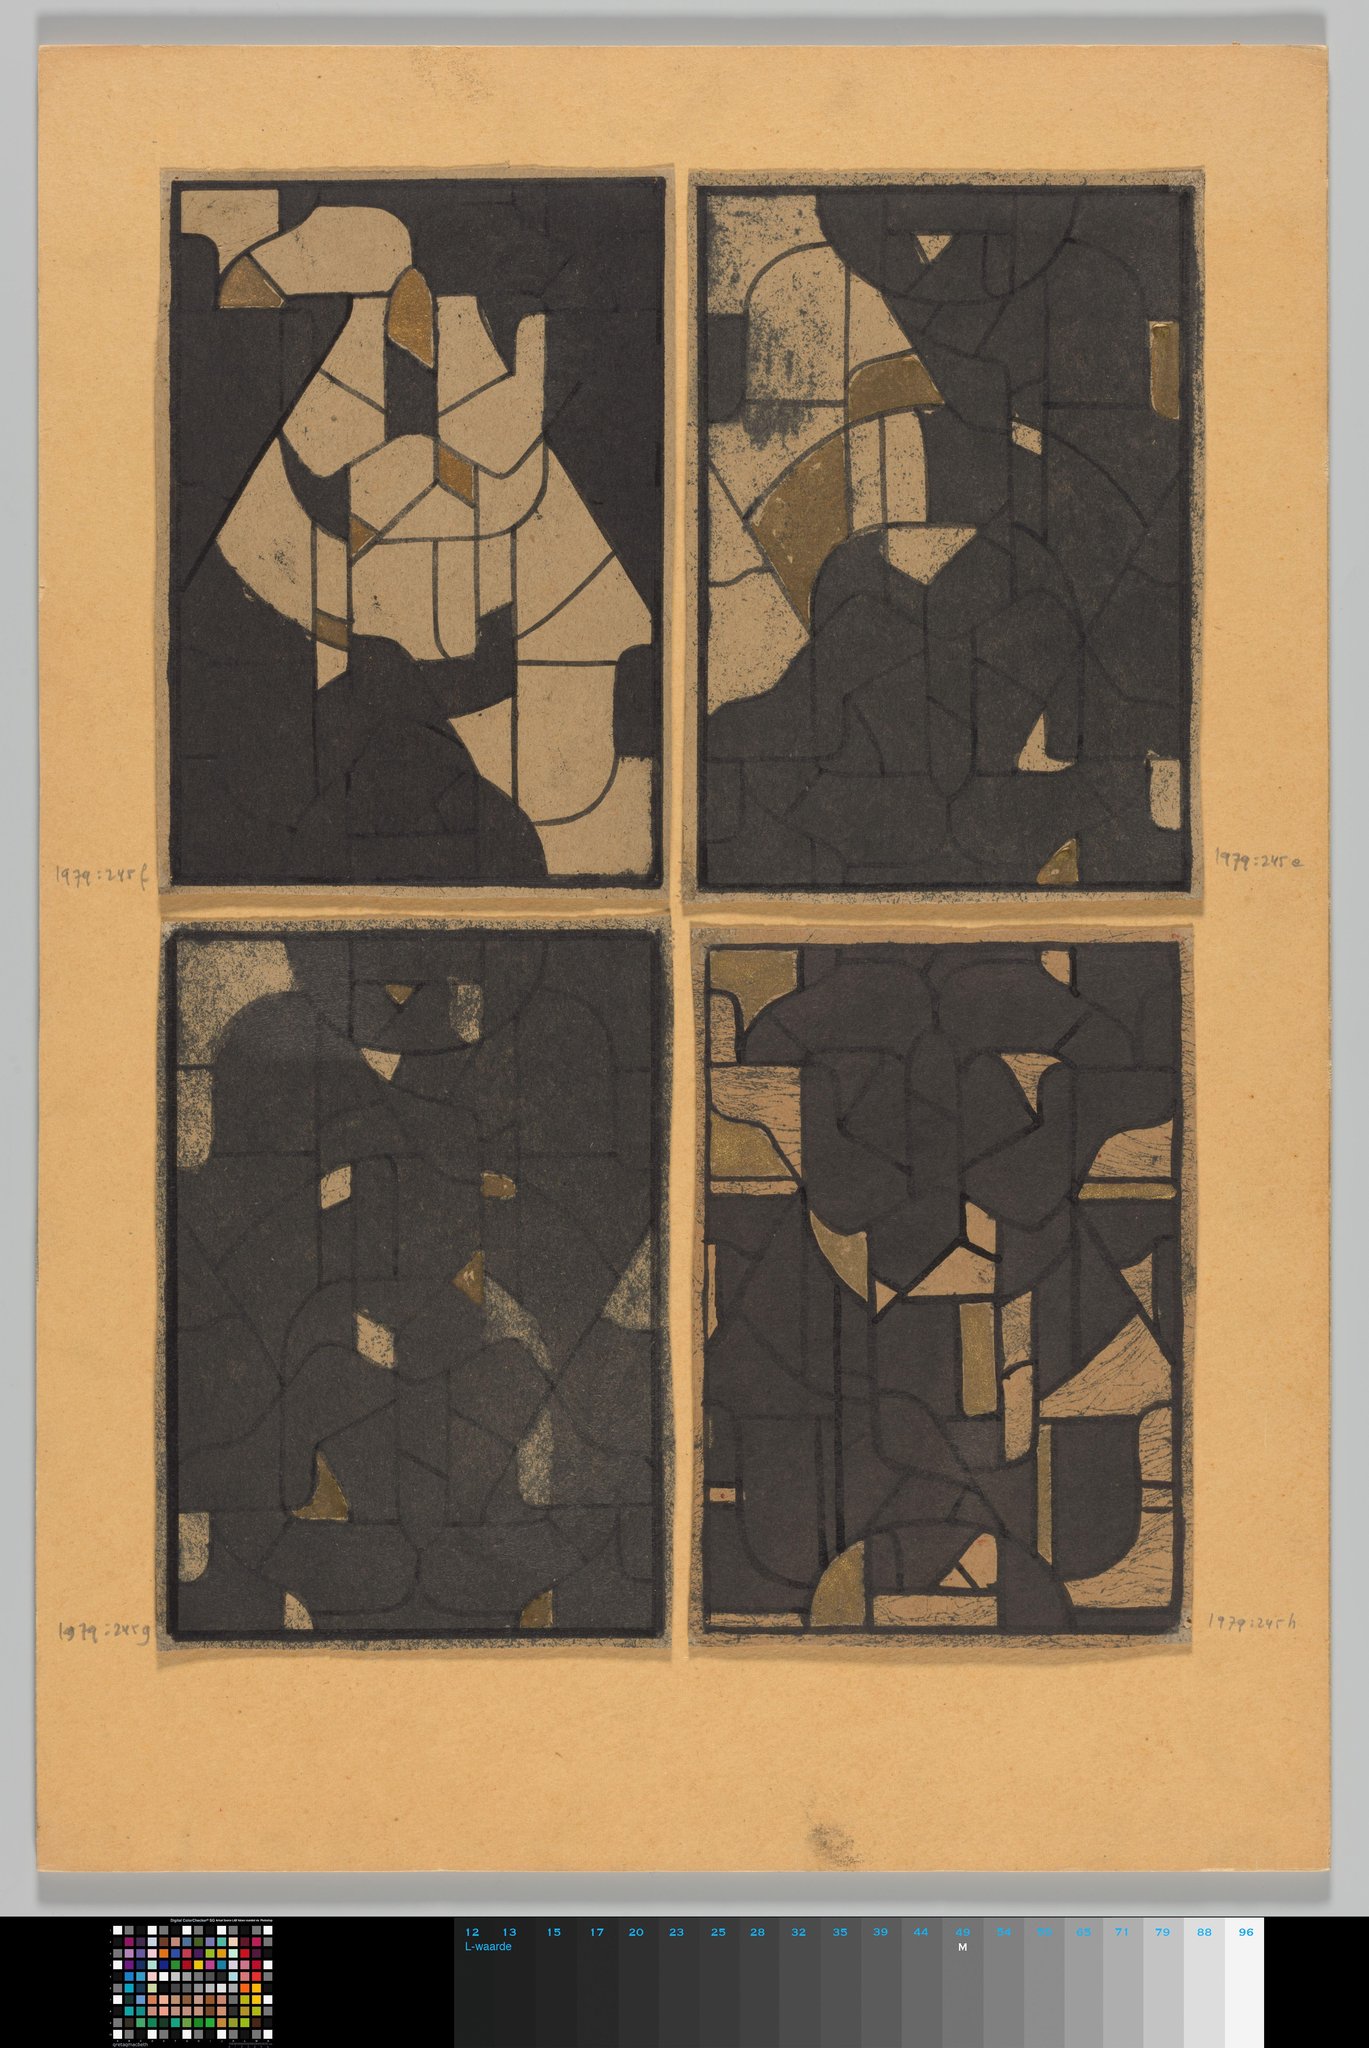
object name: drawing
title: Tapijtontwerp voor raam in het Noordertransept van de Dom te Utrecht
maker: richard nicolaüs roland holst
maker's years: 1868-1938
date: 1868-1938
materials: cardboard, paper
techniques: brush